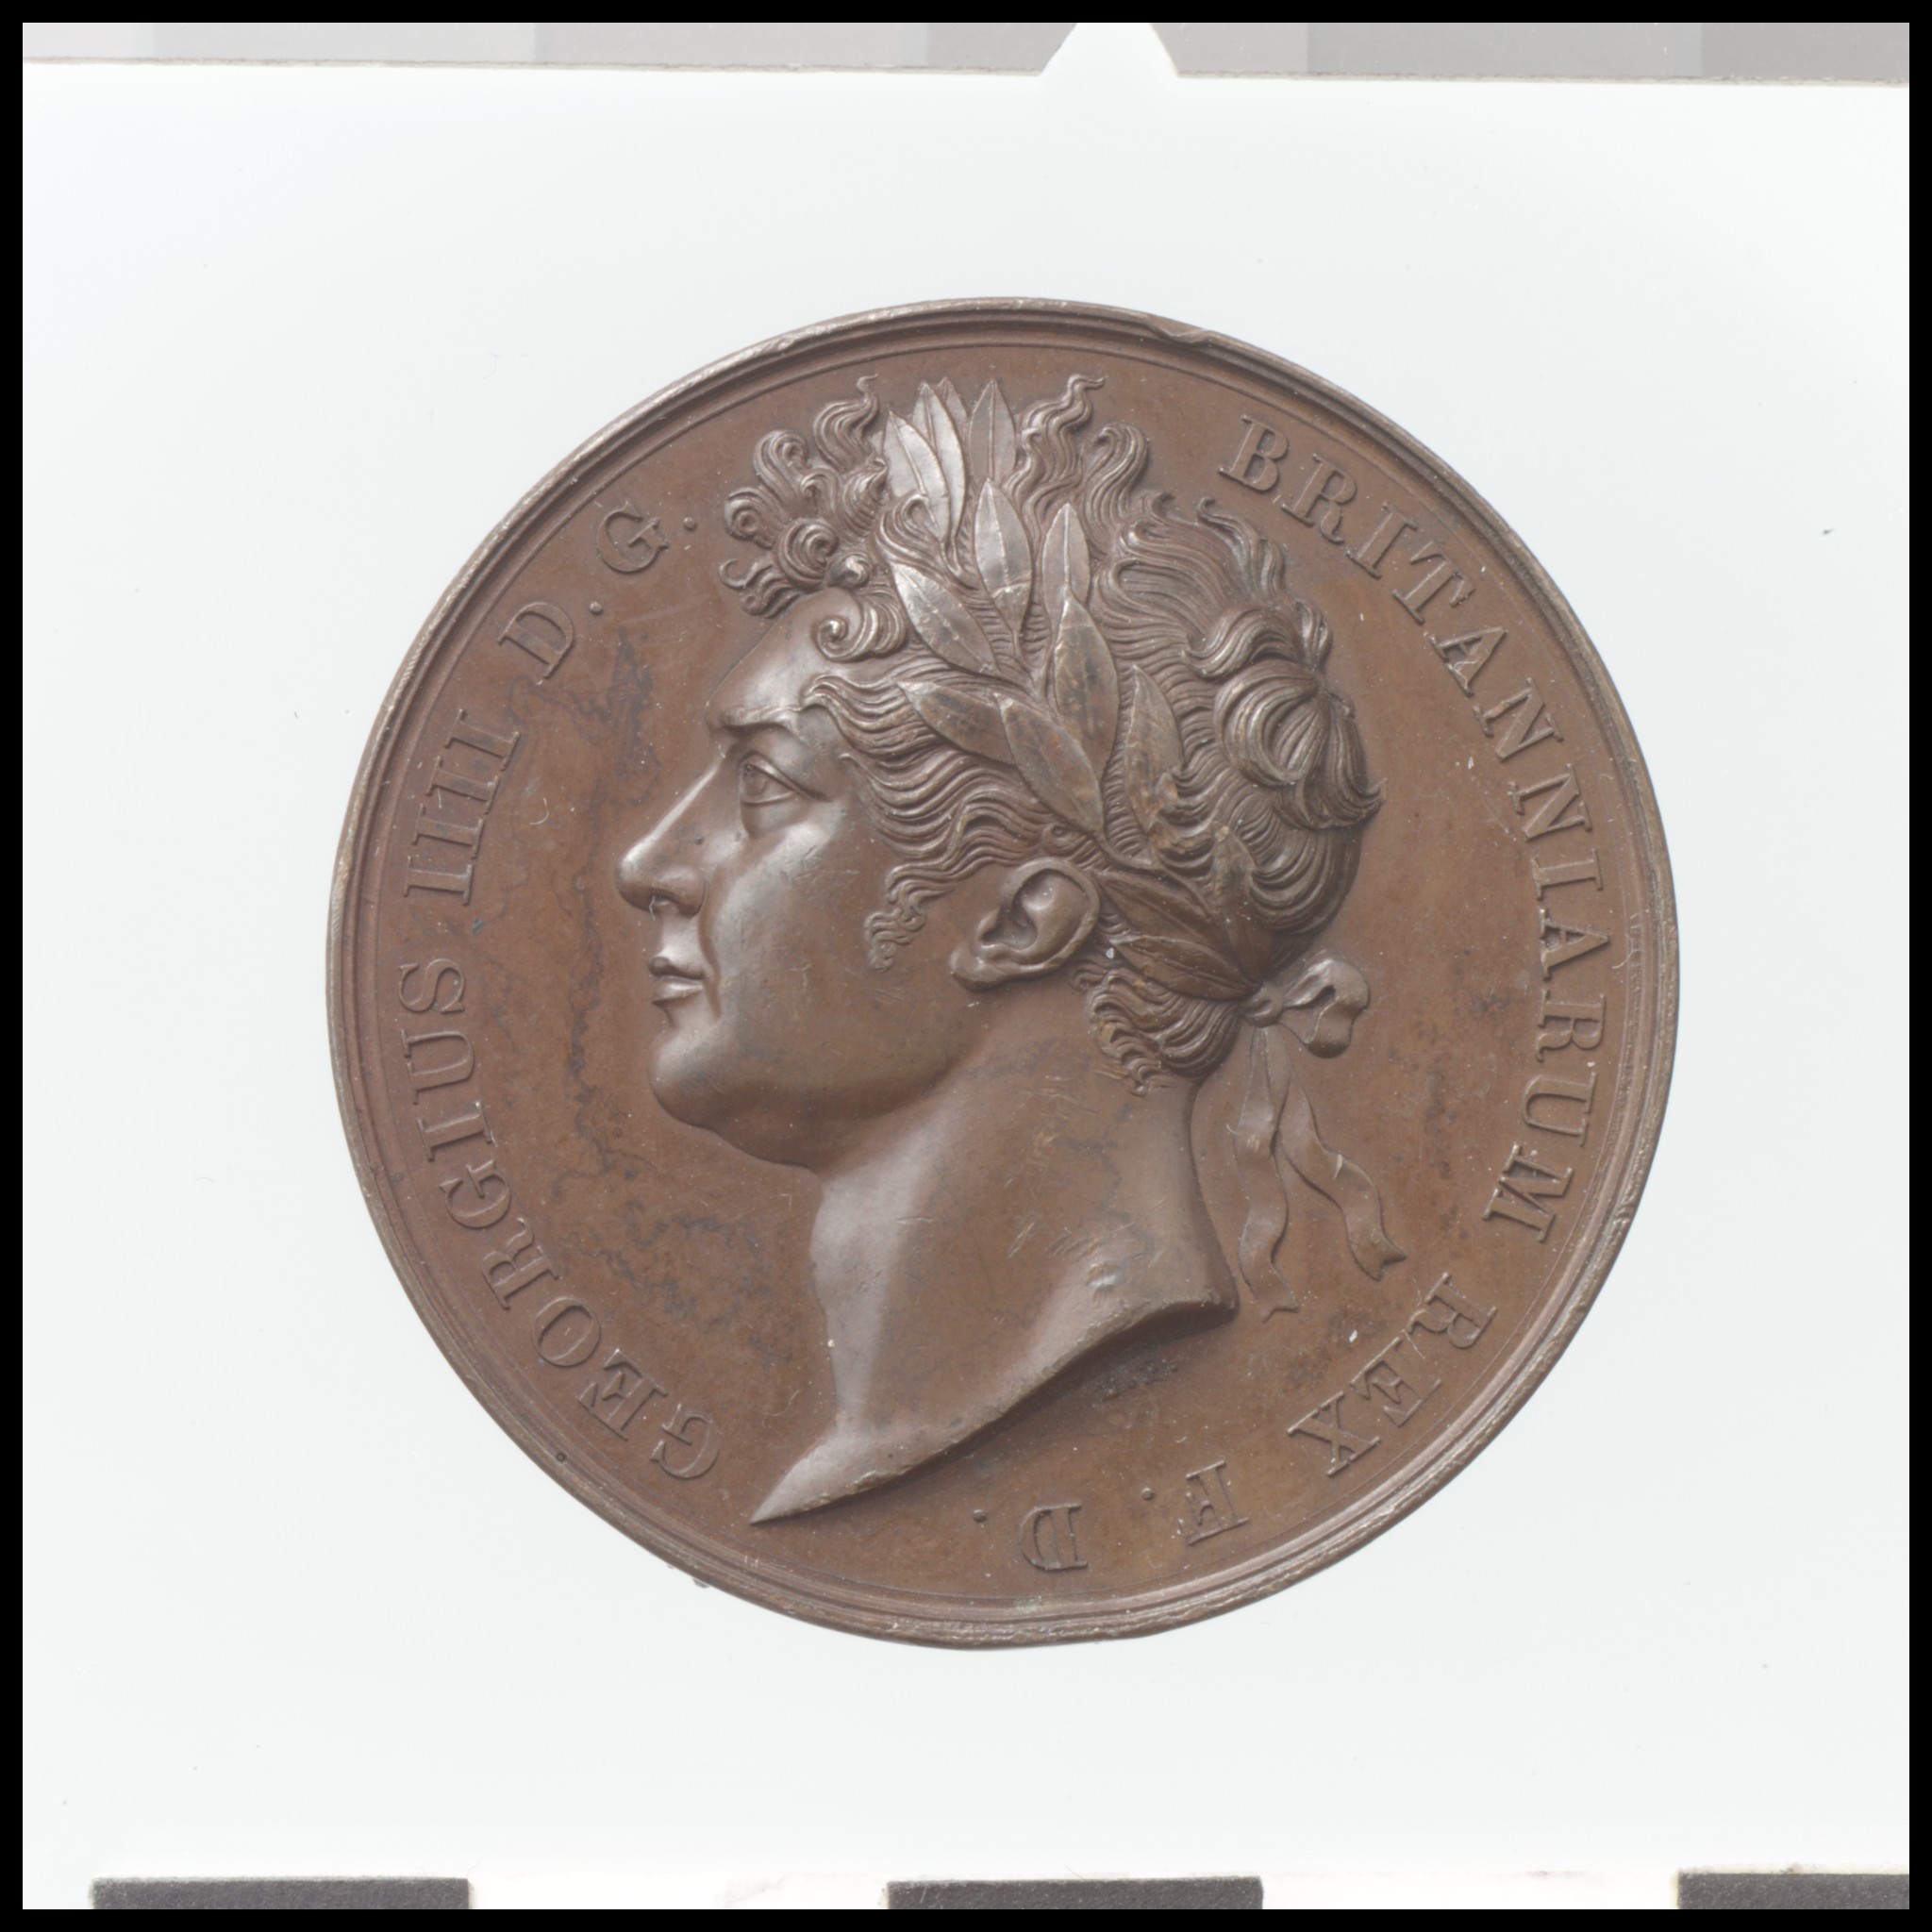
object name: medal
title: Coronation of George IV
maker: benedetto pistrucci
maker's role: maker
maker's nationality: italian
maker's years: 1783-1855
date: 1821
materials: bronze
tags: kings,men,profiles